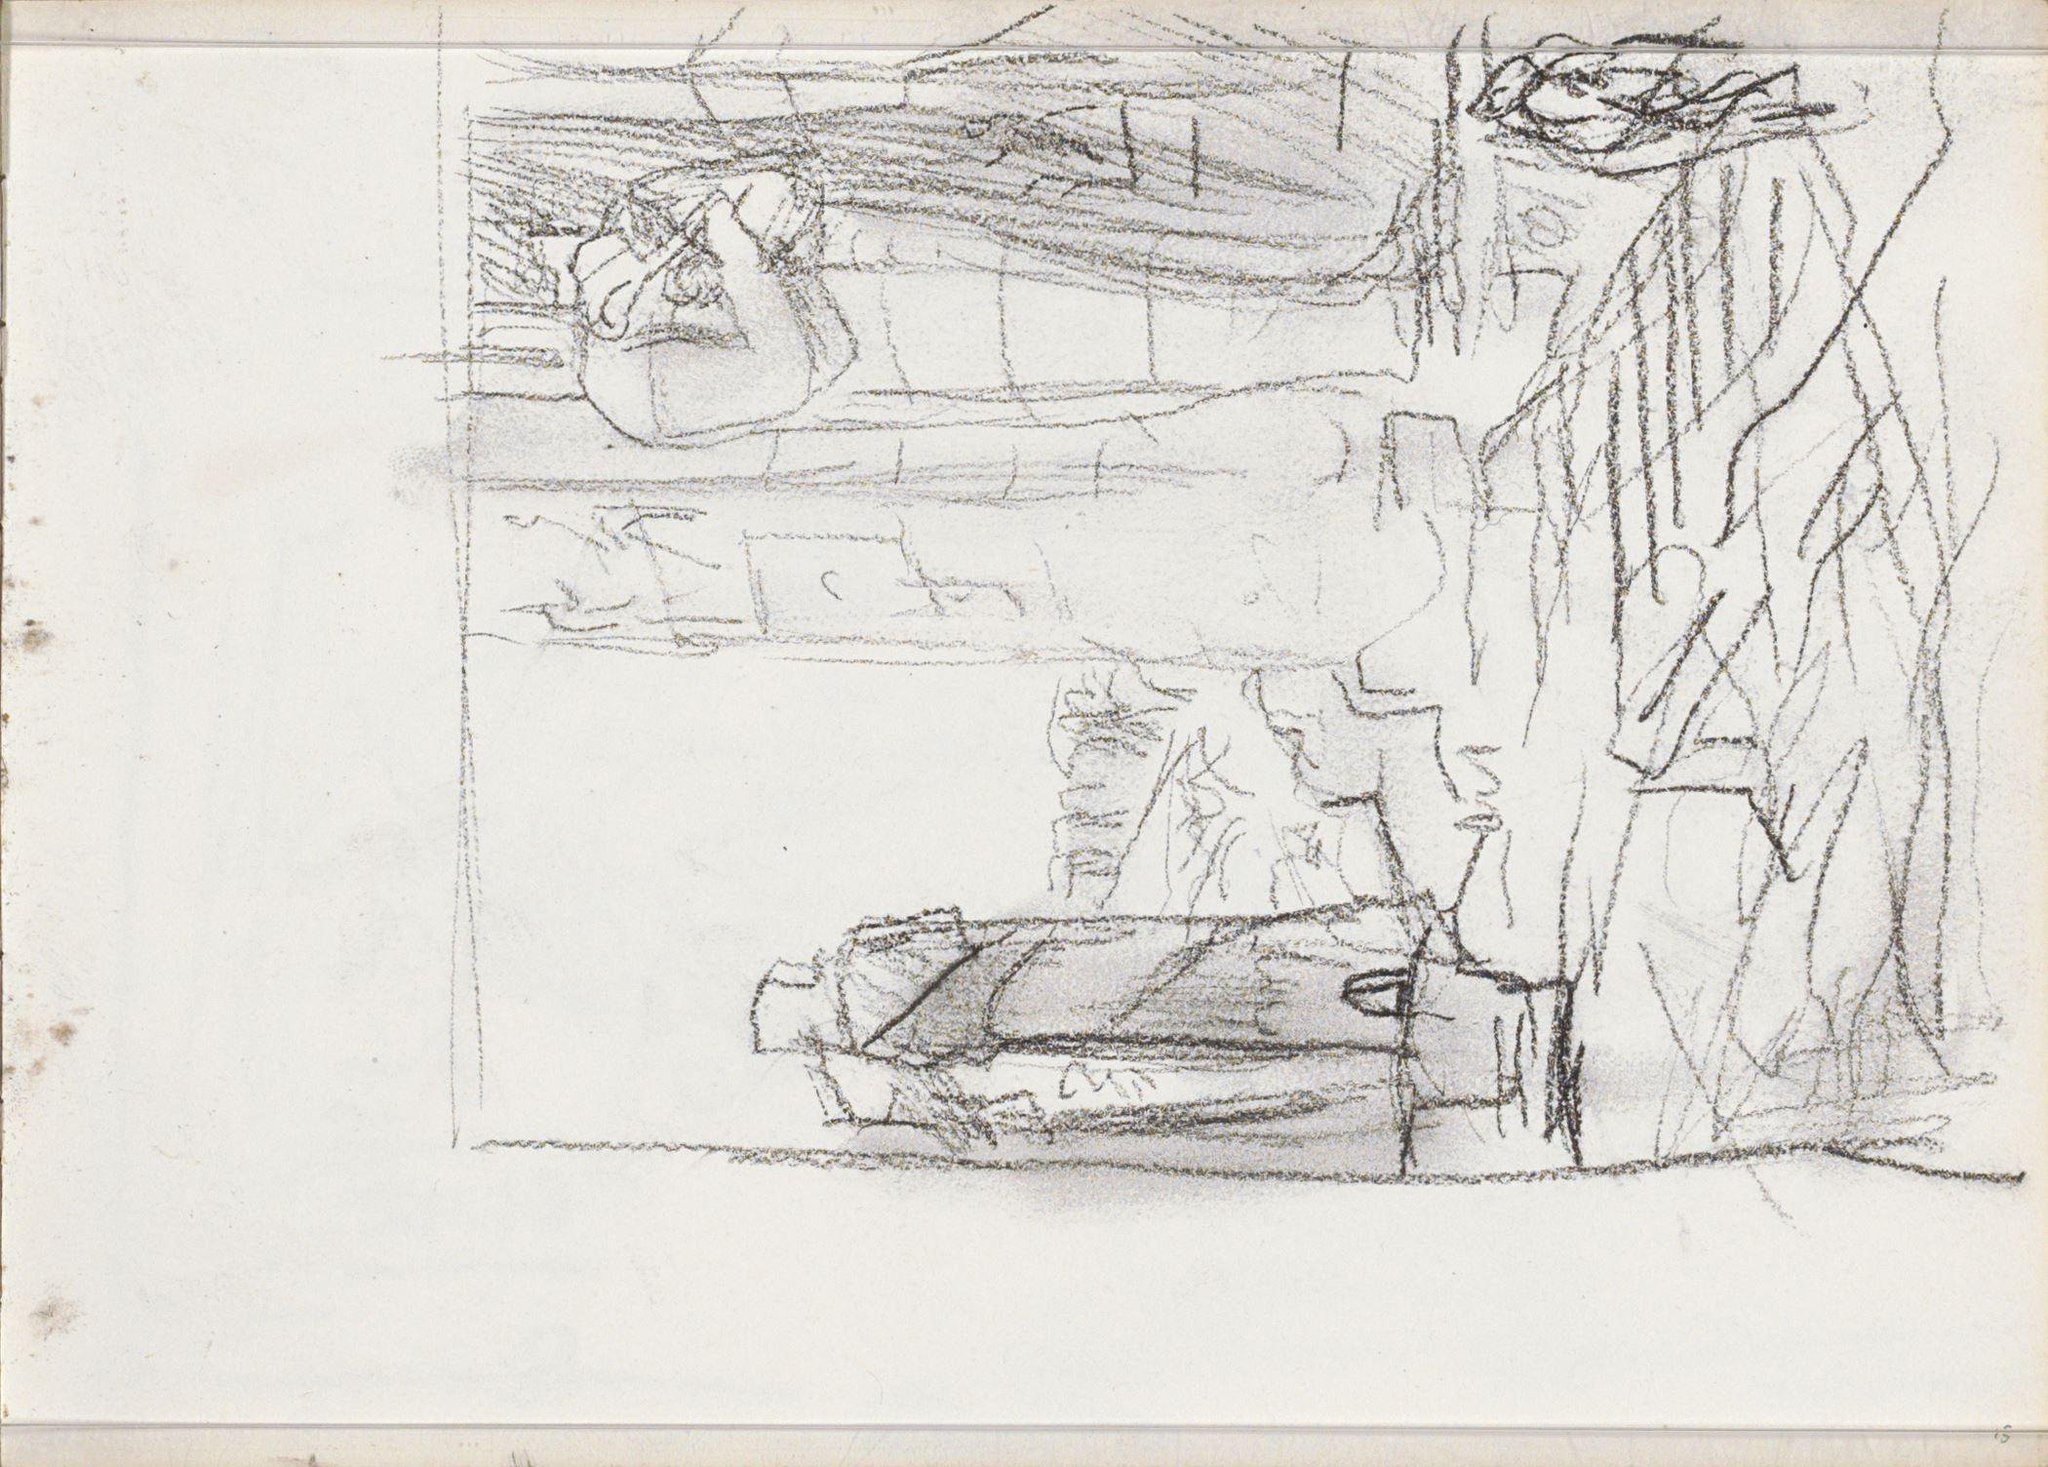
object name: sketchbook leaf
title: Tempelruïne, mogelijk de Tempel van Karnak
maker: marius bauer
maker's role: draughtsman, print maker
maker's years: 1867-1932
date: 1919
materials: chalk, paper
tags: temple, shrine ~ egyptian religion, ruin of a building ~ architecture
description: Pagina 15 uit een schetsboek met 23 bladen.